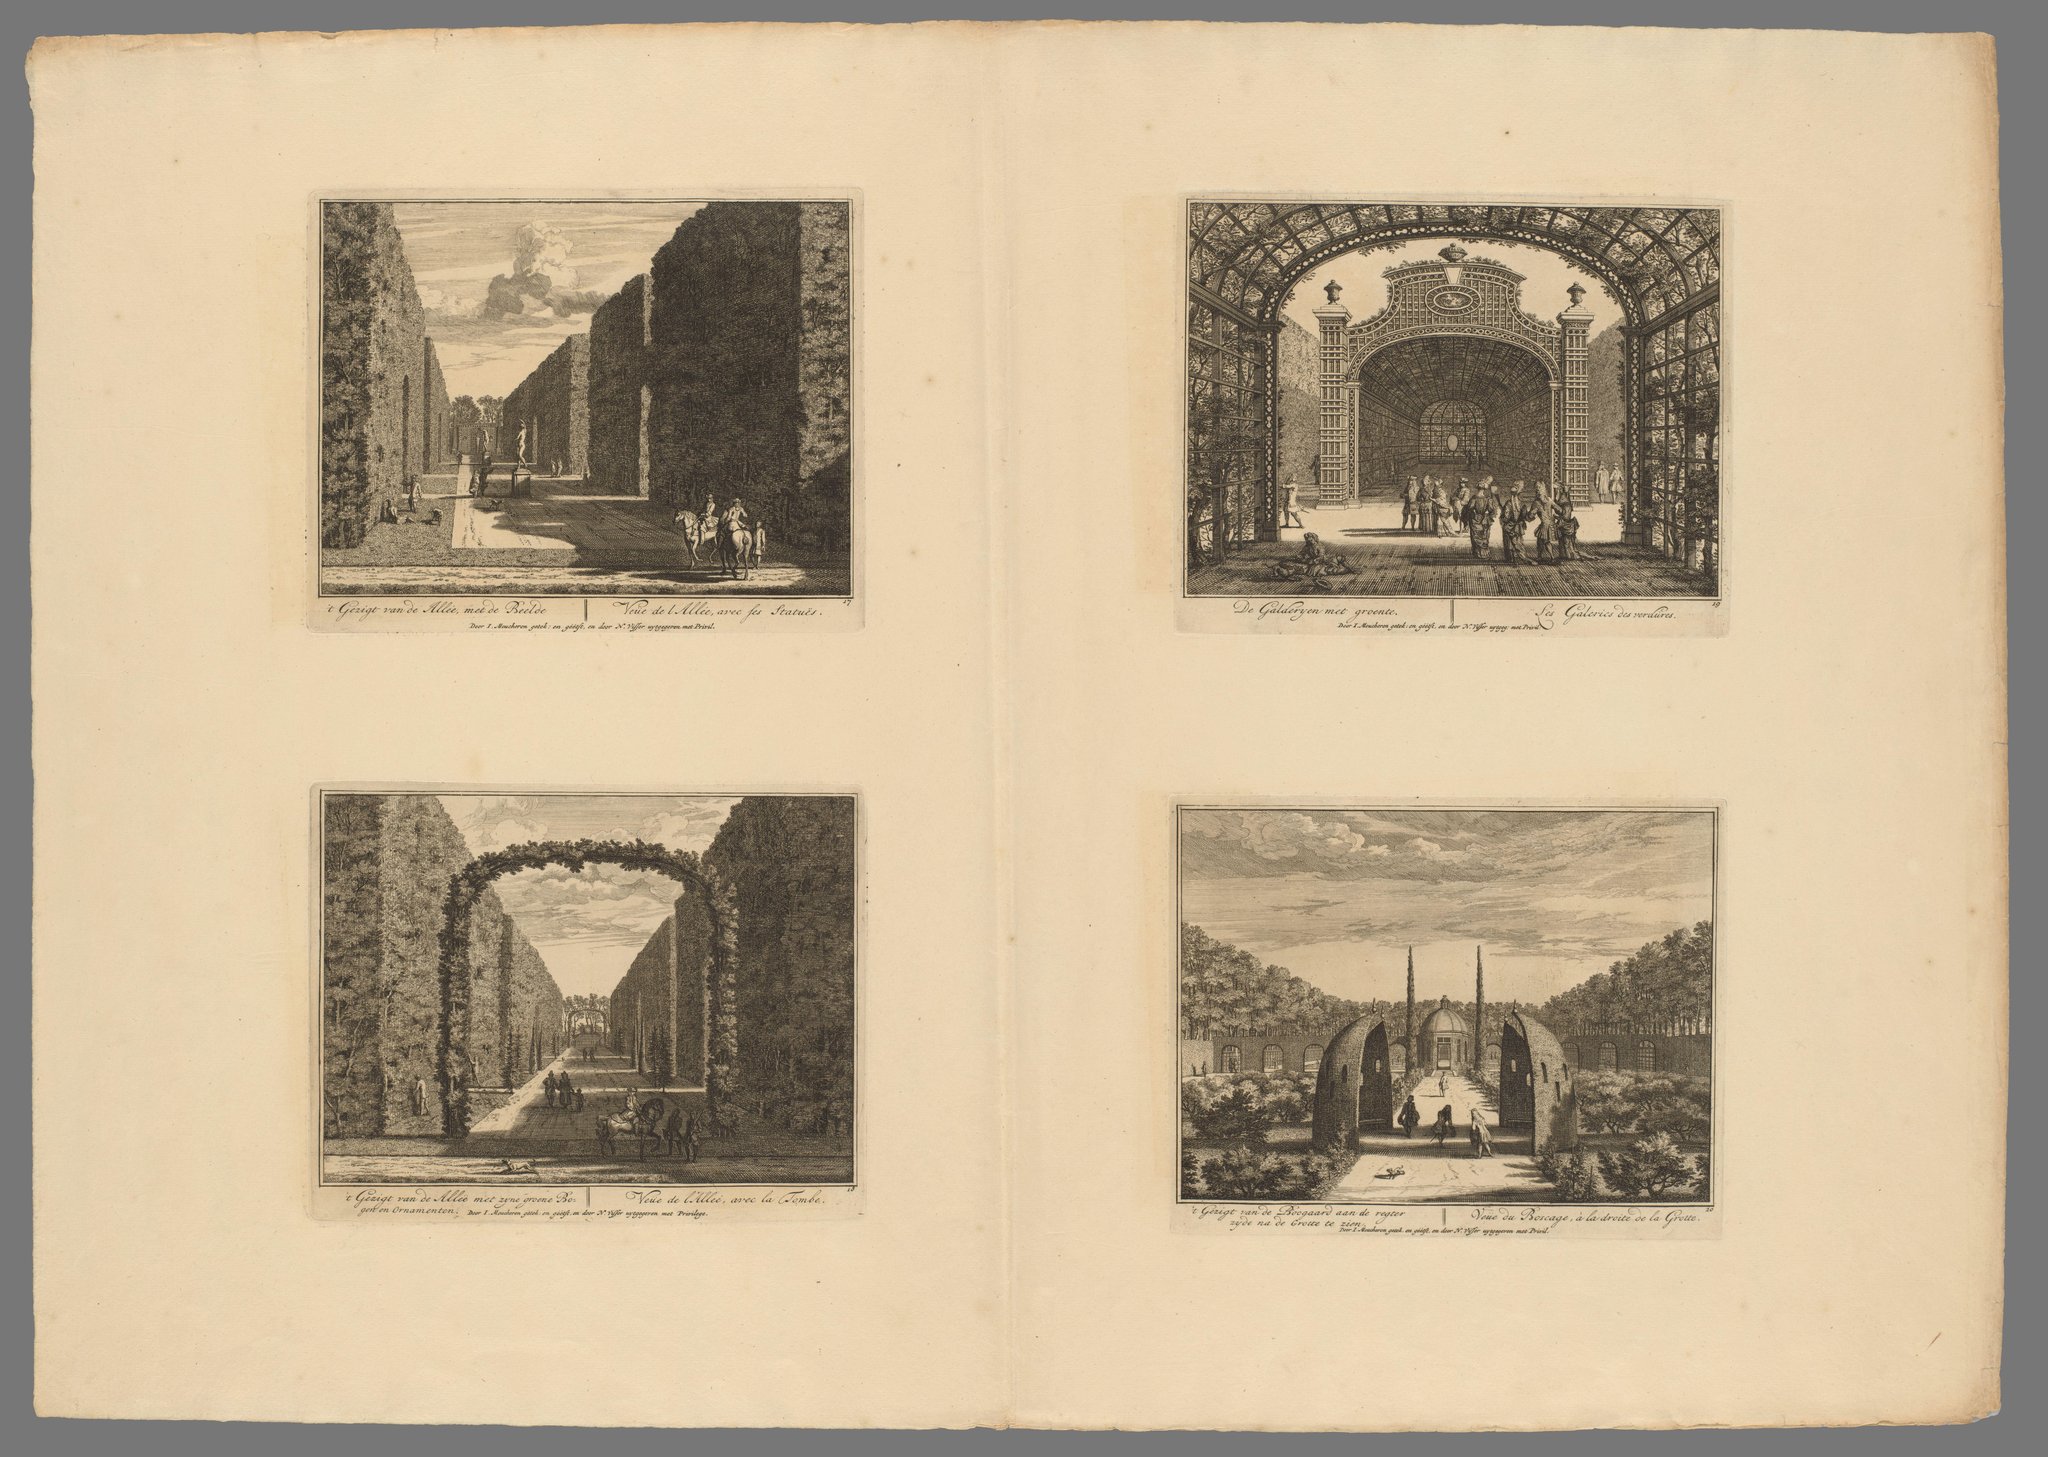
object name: print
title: Gezichten op Kasteel Heemstede in de provincie Utrecht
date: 1706-1719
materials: paper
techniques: engraving, etching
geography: amsterdam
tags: french or architectonic garden; formal garden, pergola, artificial grotto in garden, statues, sculptures in garden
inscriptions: collector's mark: Lugt 2228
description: Vier voorstellingen. Linksboven: laan met beelden in de tuin van Kasteel Heemstede. In de laan ruiters en wandelaars. Linksonder: begroeide bogen over een laan in de tuin van Kasteel Heemstede. Rechtsboven: begroeide galerijen in de tuin van Kasteel Heemstede. Mannen en vrouwen wandelen onder de pergola's. Rechtsonder: de boomgaard met aan het einde van de laan een grot.